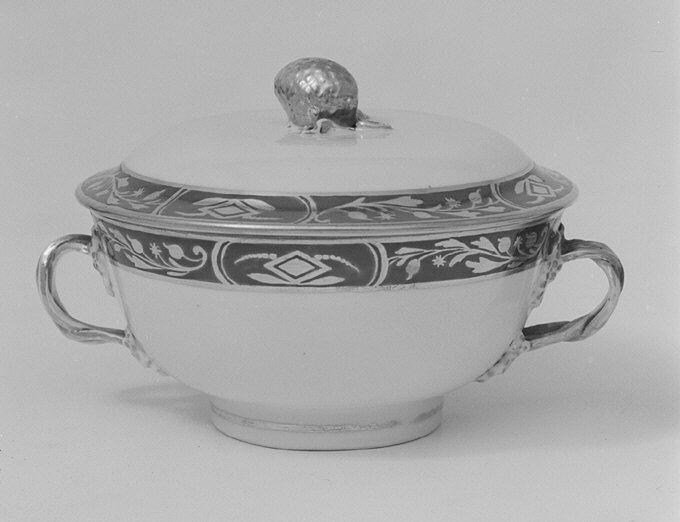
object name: sugar bowl with cover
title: Sugar bowl with cover (part of a service)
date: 1785-1800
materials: hard paste porcelain